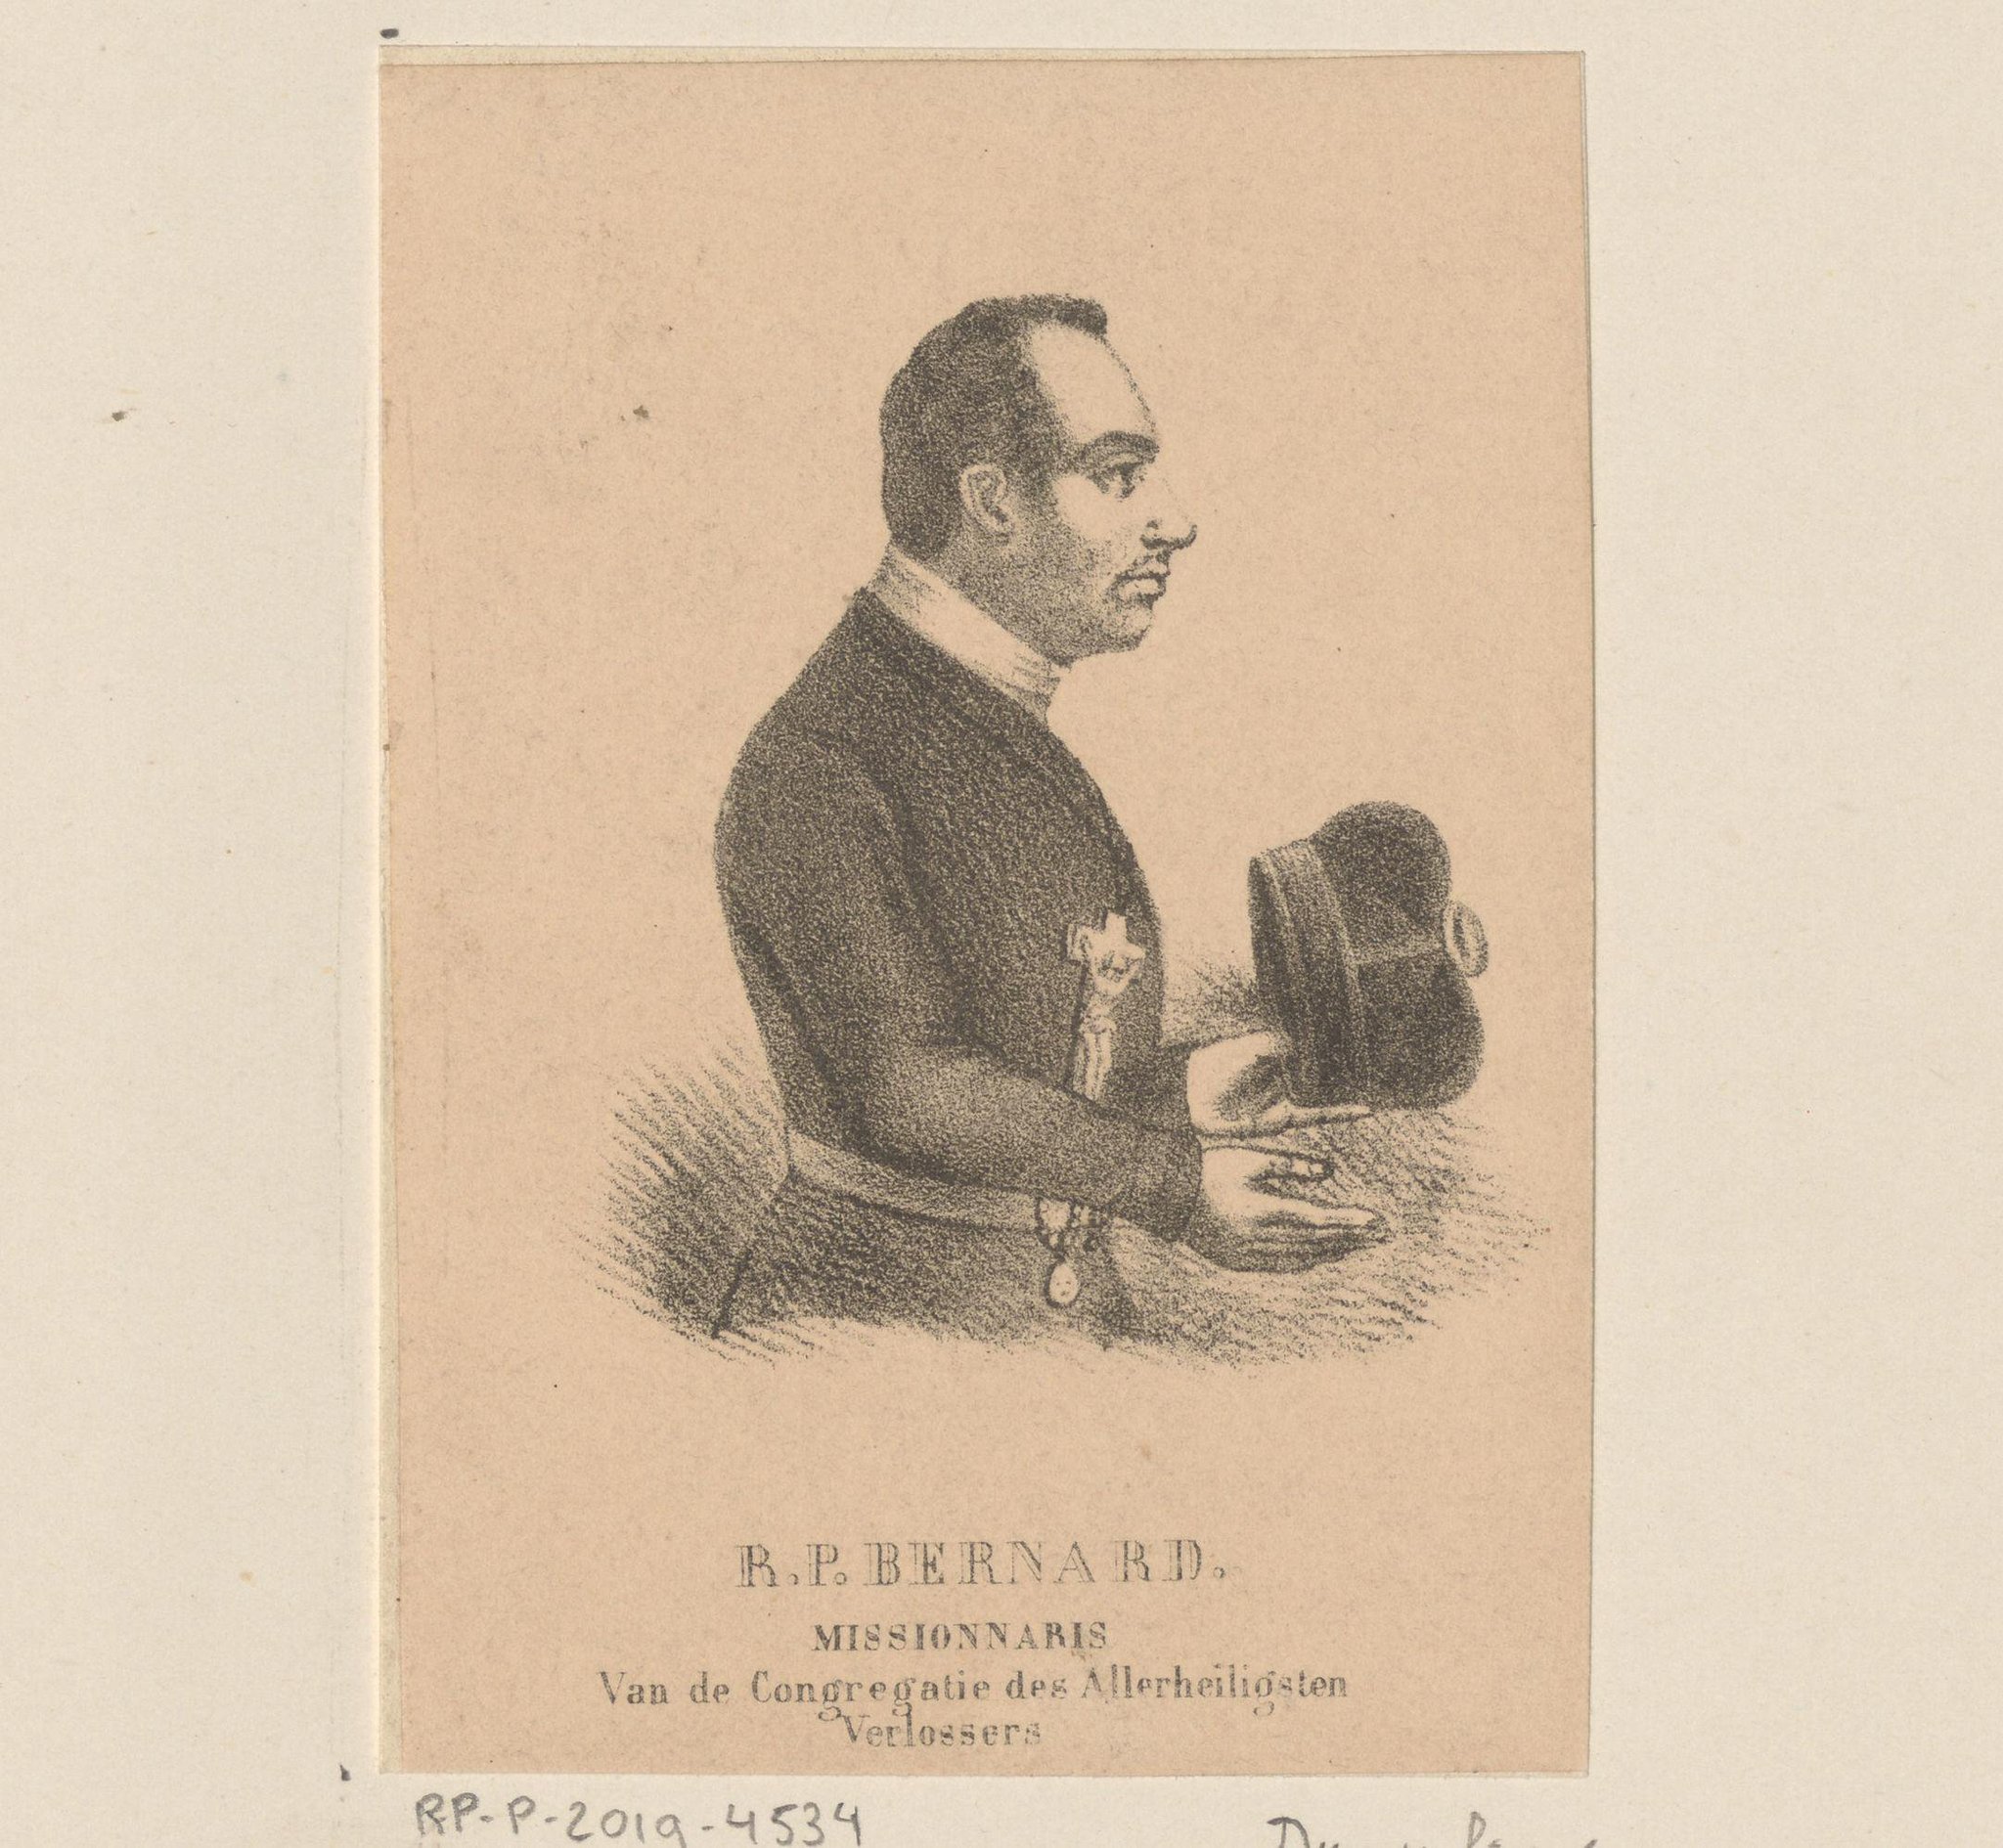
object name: print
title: Portret van Bernard Hafkenscheid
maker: Anonymous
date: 1830-1880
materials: paper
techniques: lithograph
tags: amsterdam, historical persons, crucifix ~ personal devotion